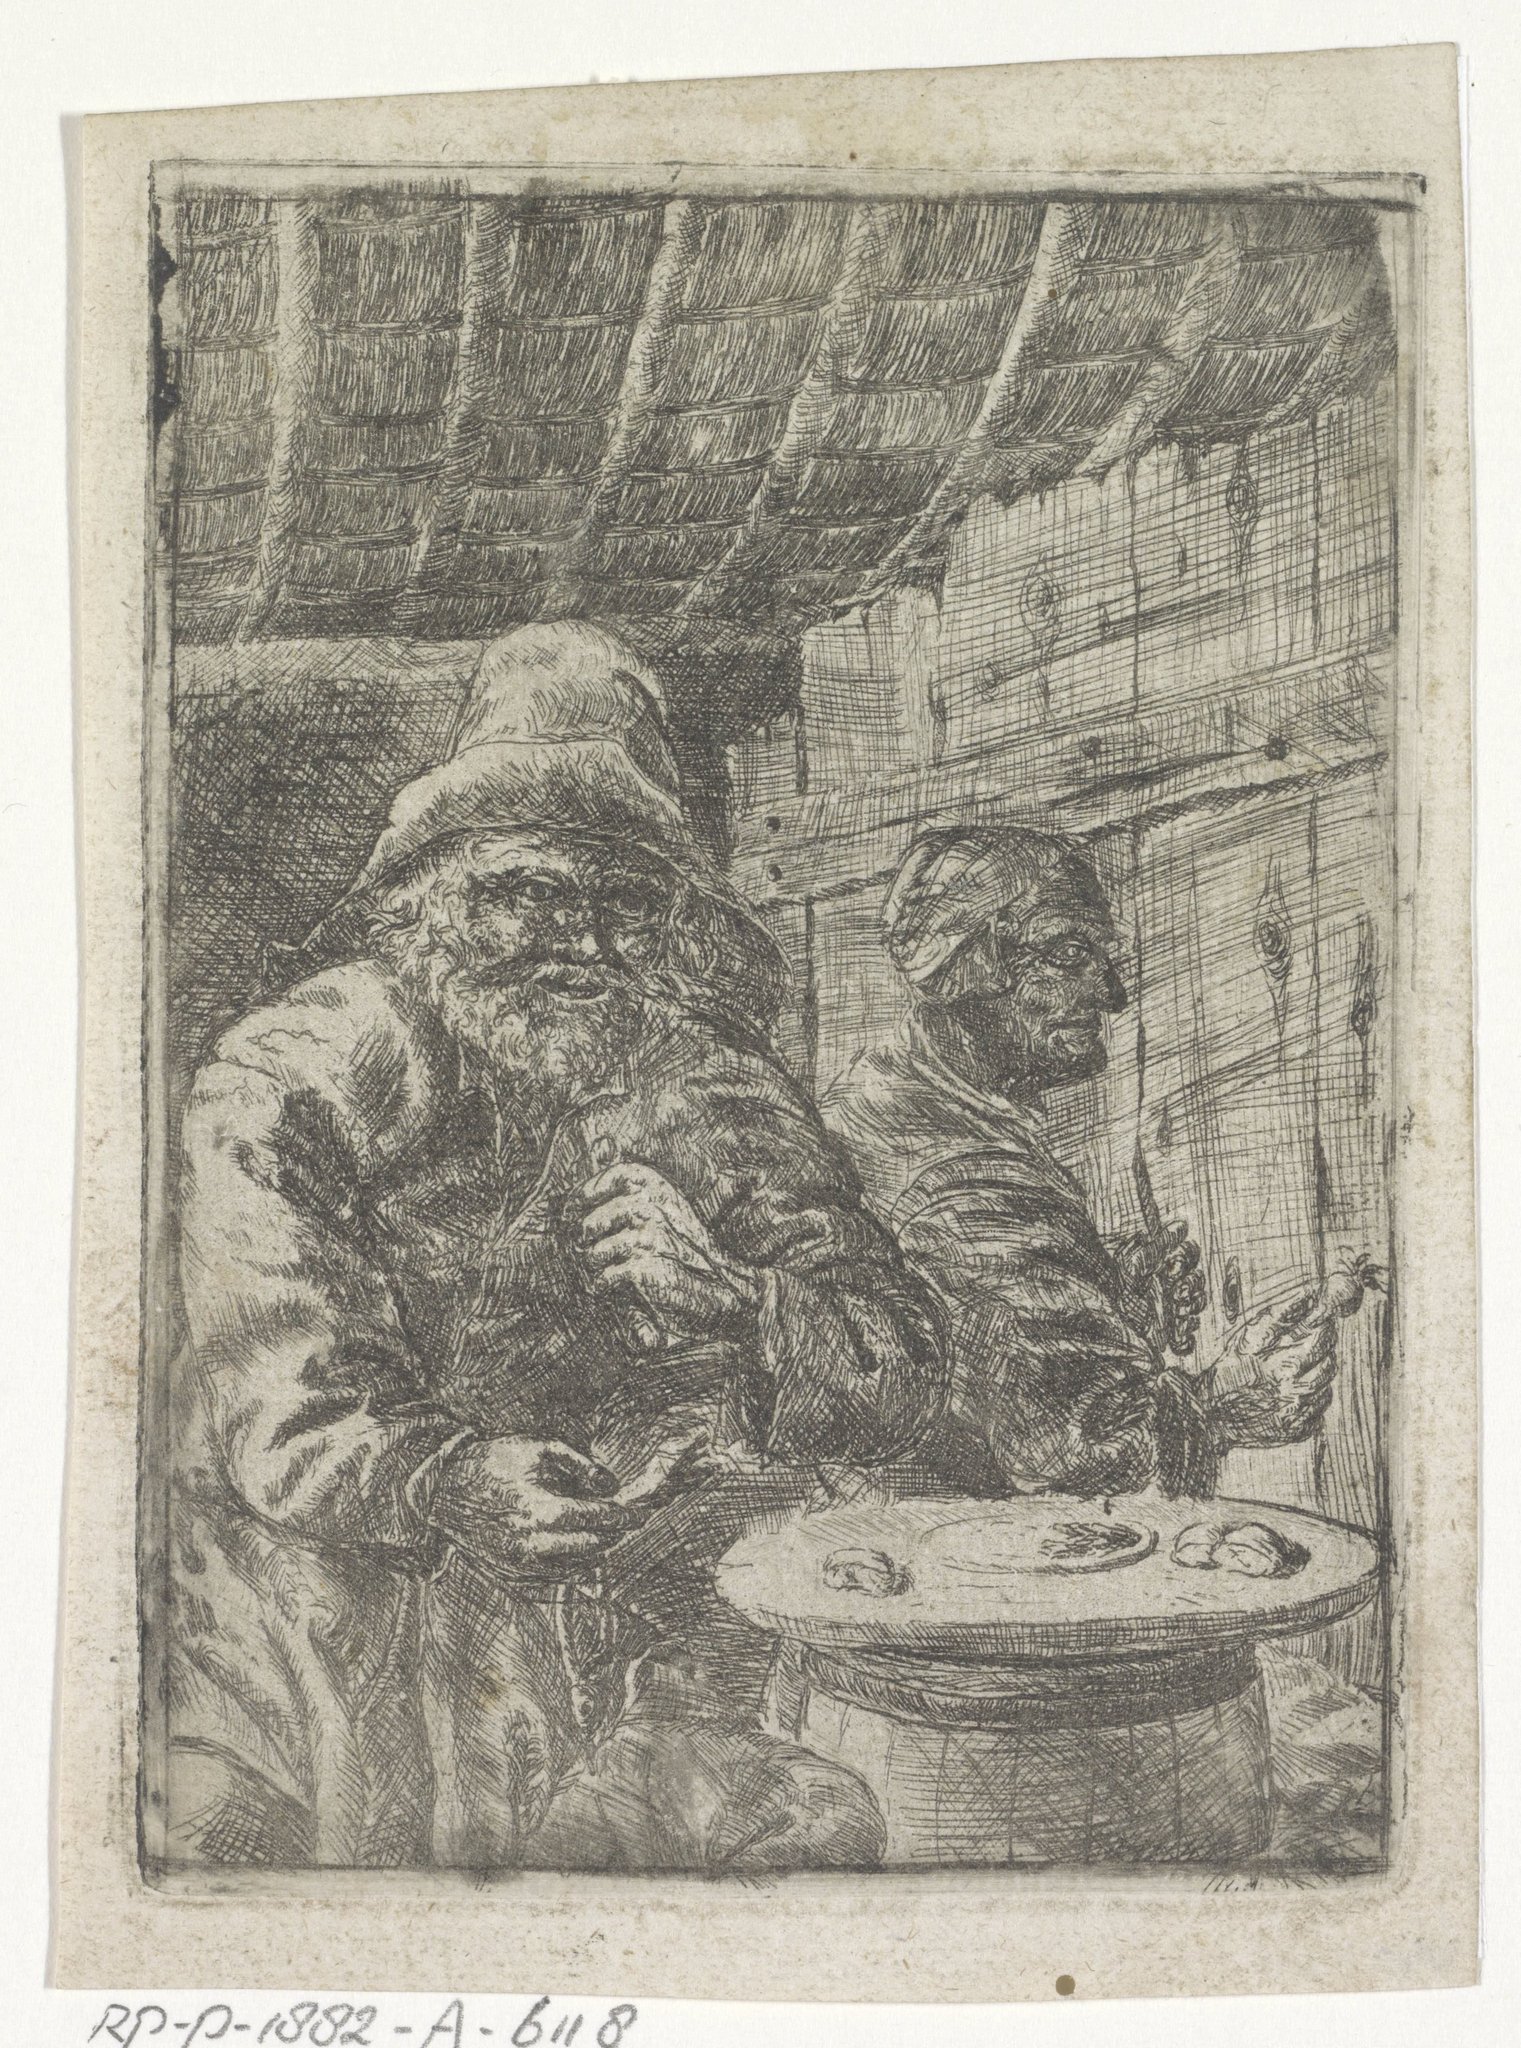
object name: print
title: Boer bij een ton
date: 1690-1750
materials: paper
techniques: etching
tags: inn, coffee-house, public house, etc.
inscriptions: collector's mark: Lugt 2228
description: Een boer zit bij een ton. Naast hem een vrouw met een mes en een wortel in de handen.